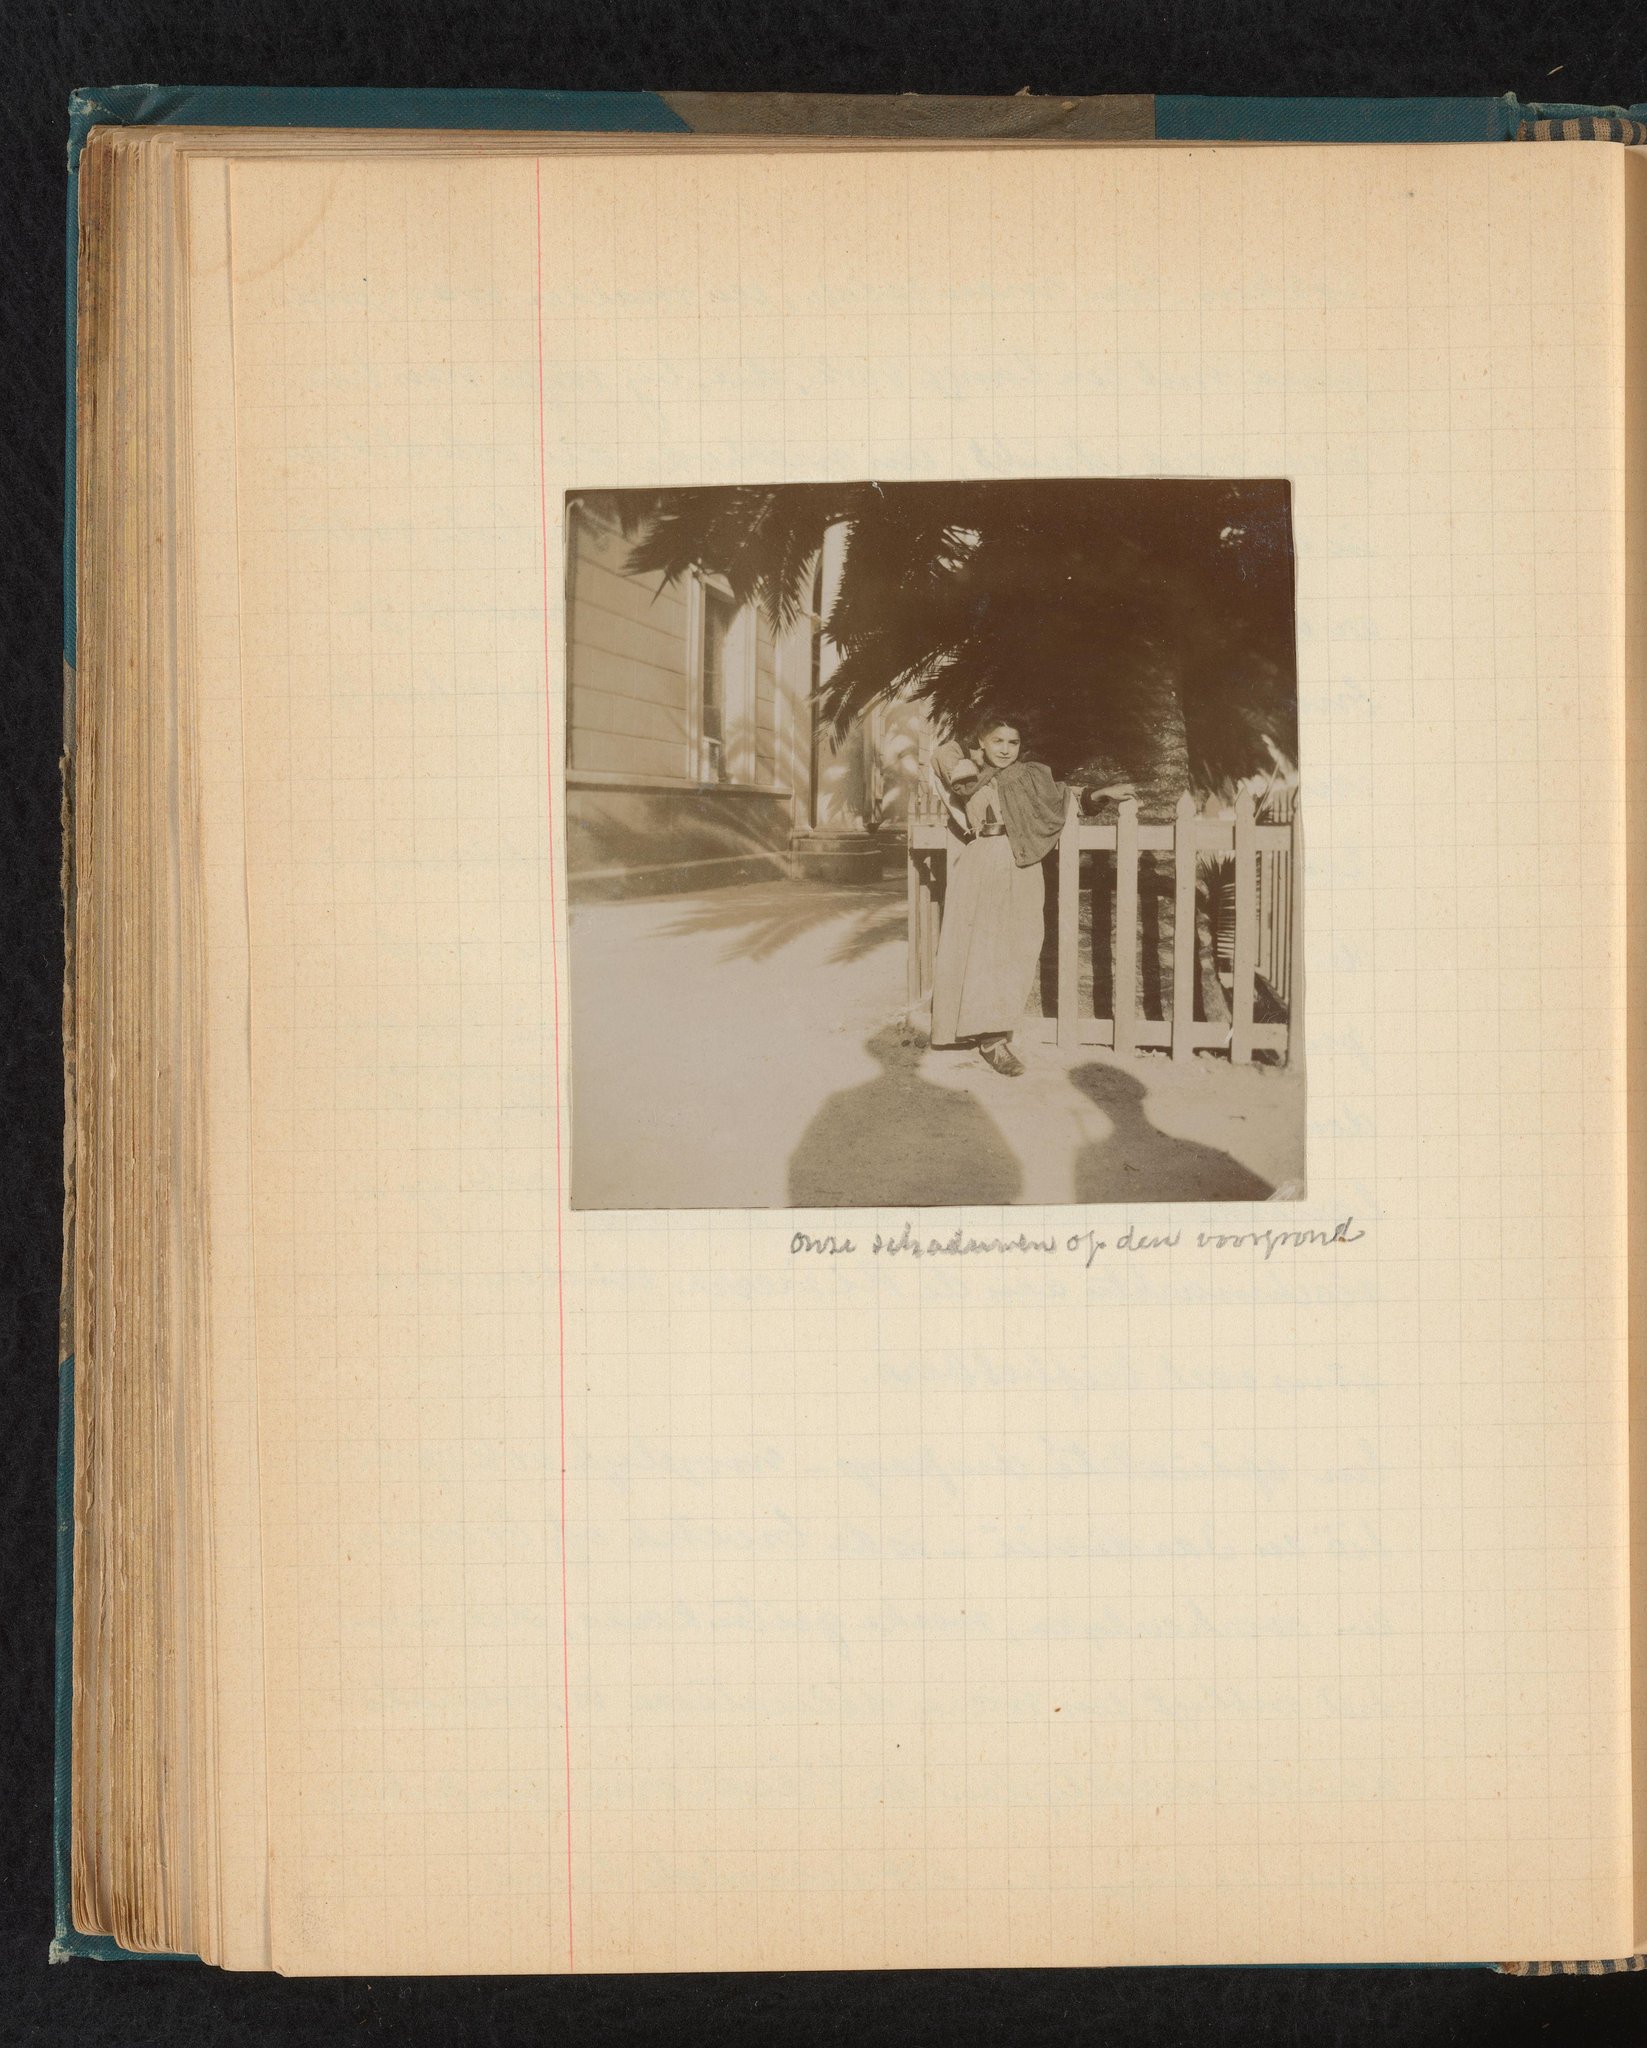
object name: photograph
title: Corsicaans meisje leunt tegen een hek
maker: théodore van lelyveld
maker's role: painter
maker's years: 1867-1954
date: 1902-1904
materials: paper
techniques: gelatin silver print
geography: ajaccio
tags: historical persons not known by name - bb - woman, leaning figure - aa - female human figure, girl (child between toddler and youth)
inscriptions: inscription: ‘onze schaduwen op den voorgrond’